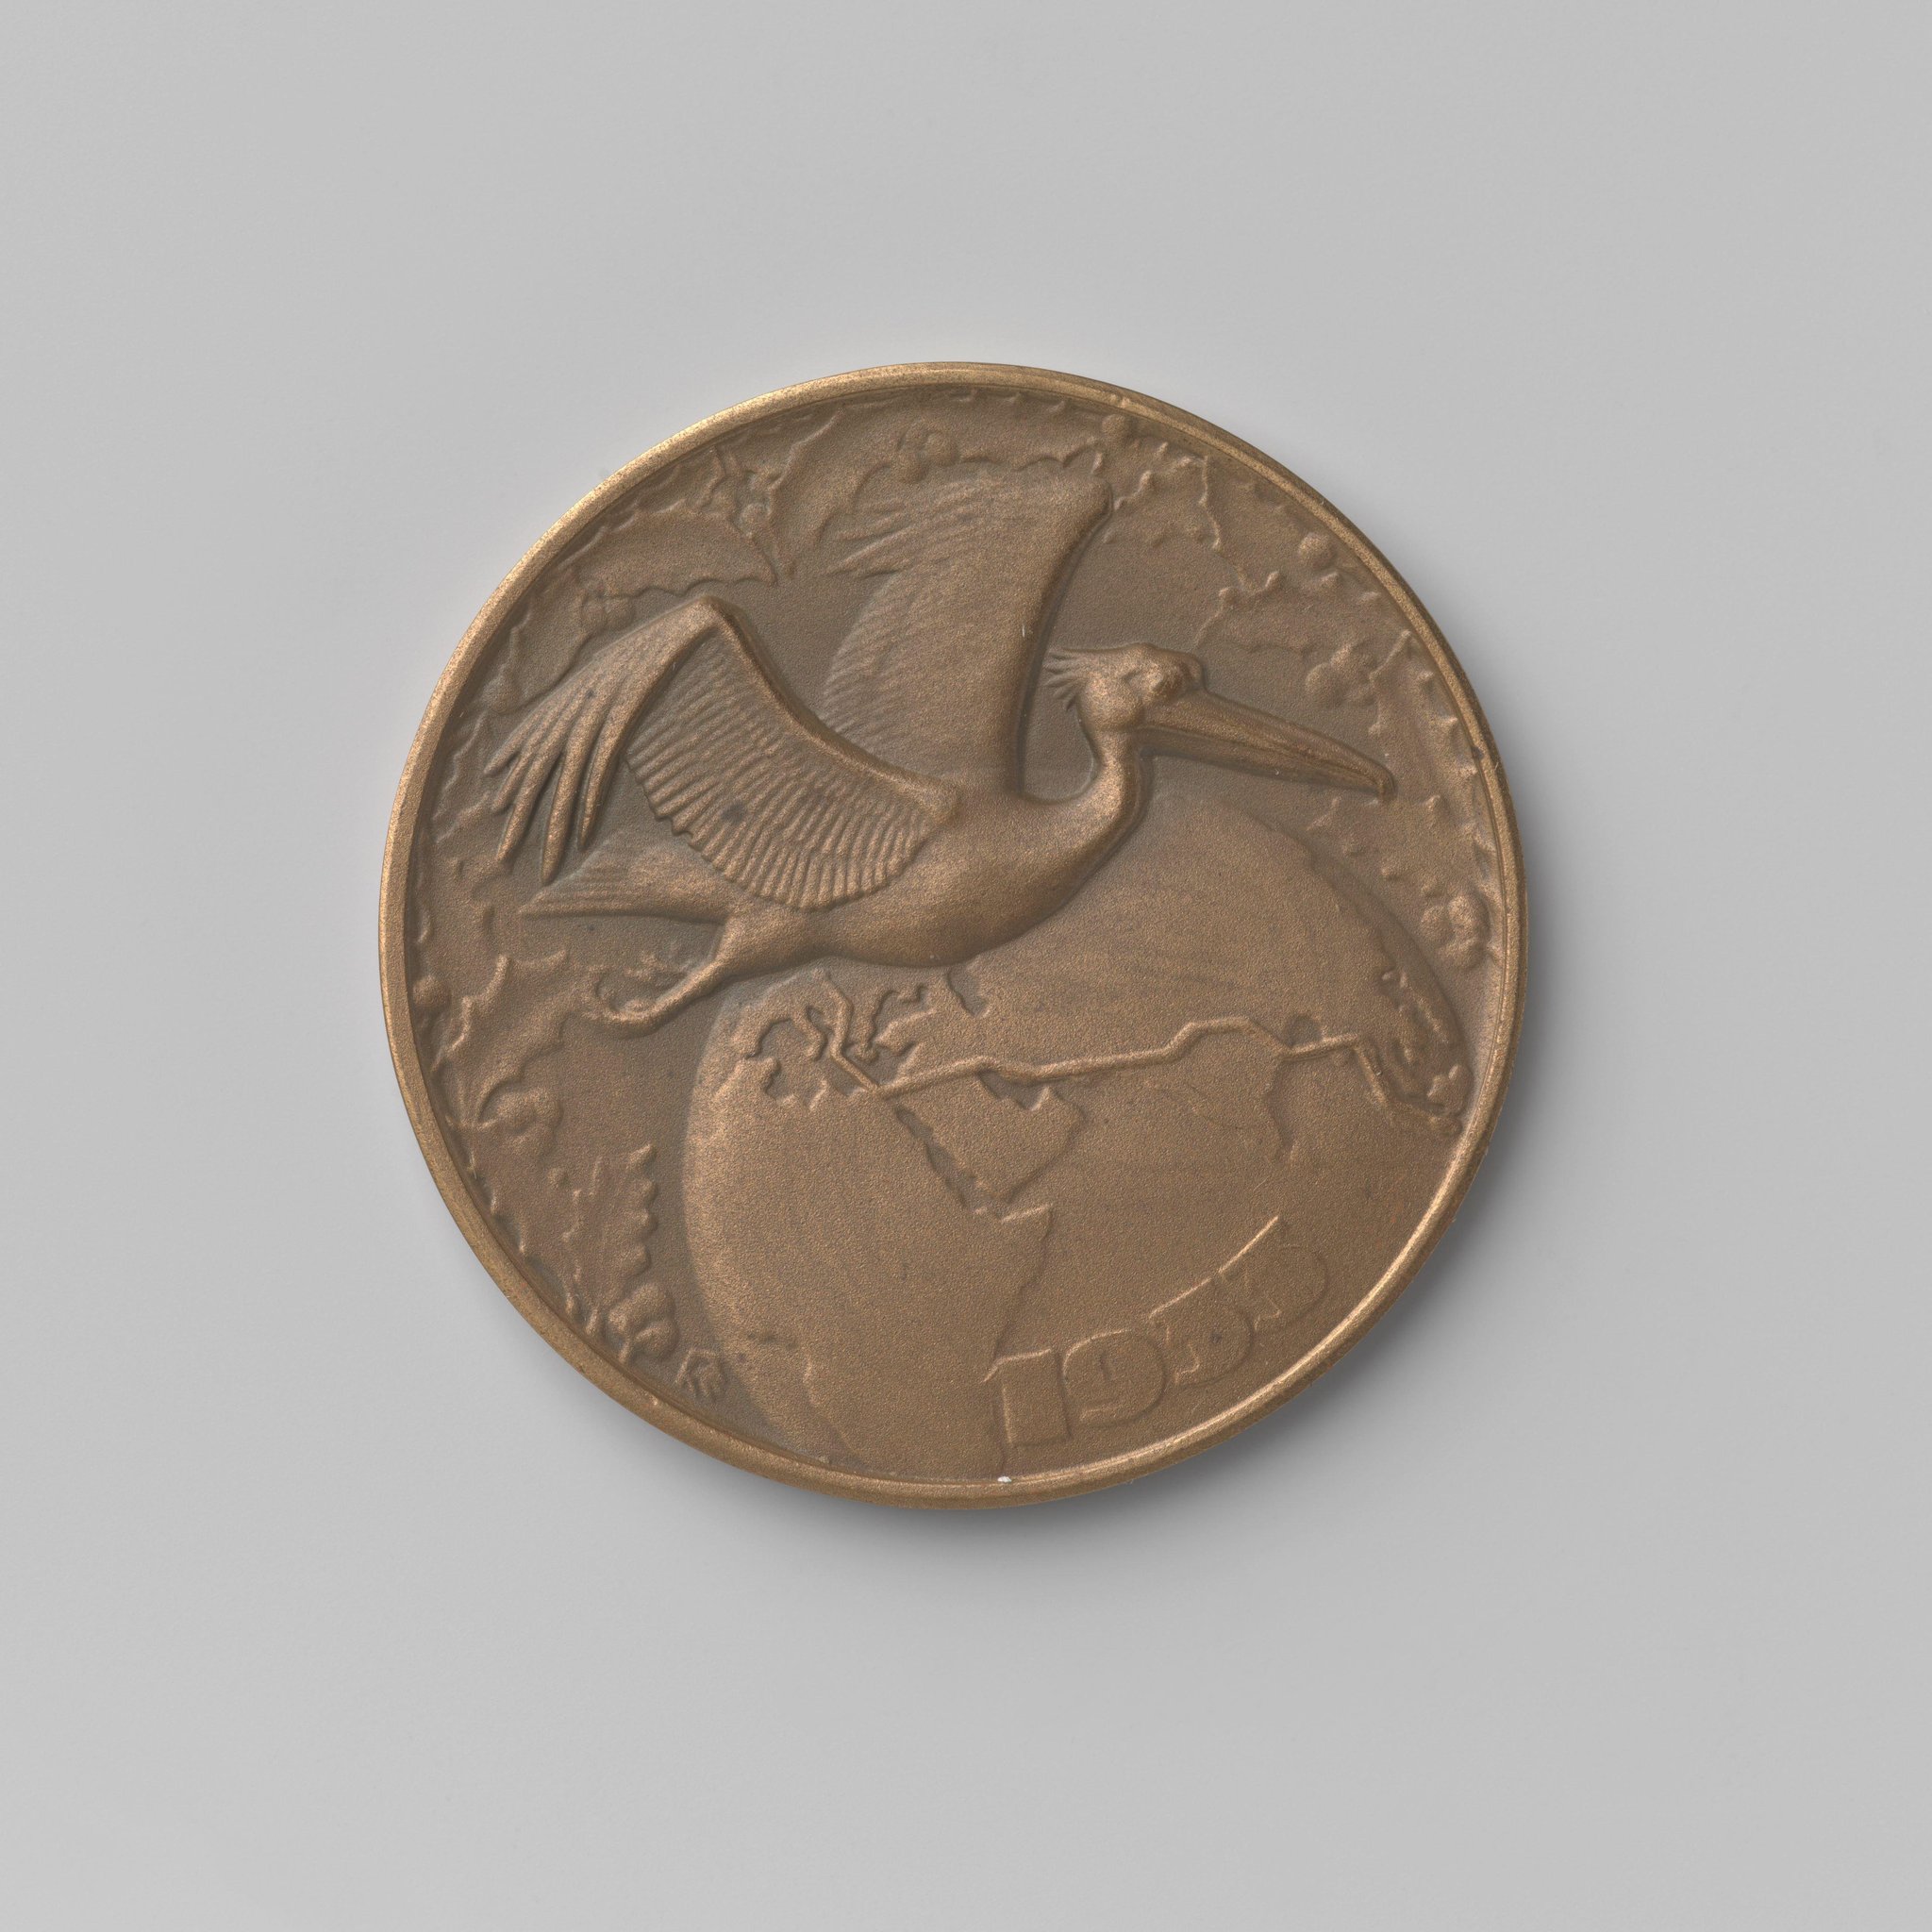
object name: history medal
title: Kersttocht Holland-Indië van de Pelikaan 1933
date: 1933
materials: bronze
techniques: striking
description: Bronzen penning, op de voorzijde een pelikaan naar rechts die rond de wereldbol vliegt, met onderaan een jaartal, op de keerzijde een opgaande zon met wolkenlucht waarin vier handtekeningen, met omschrift.